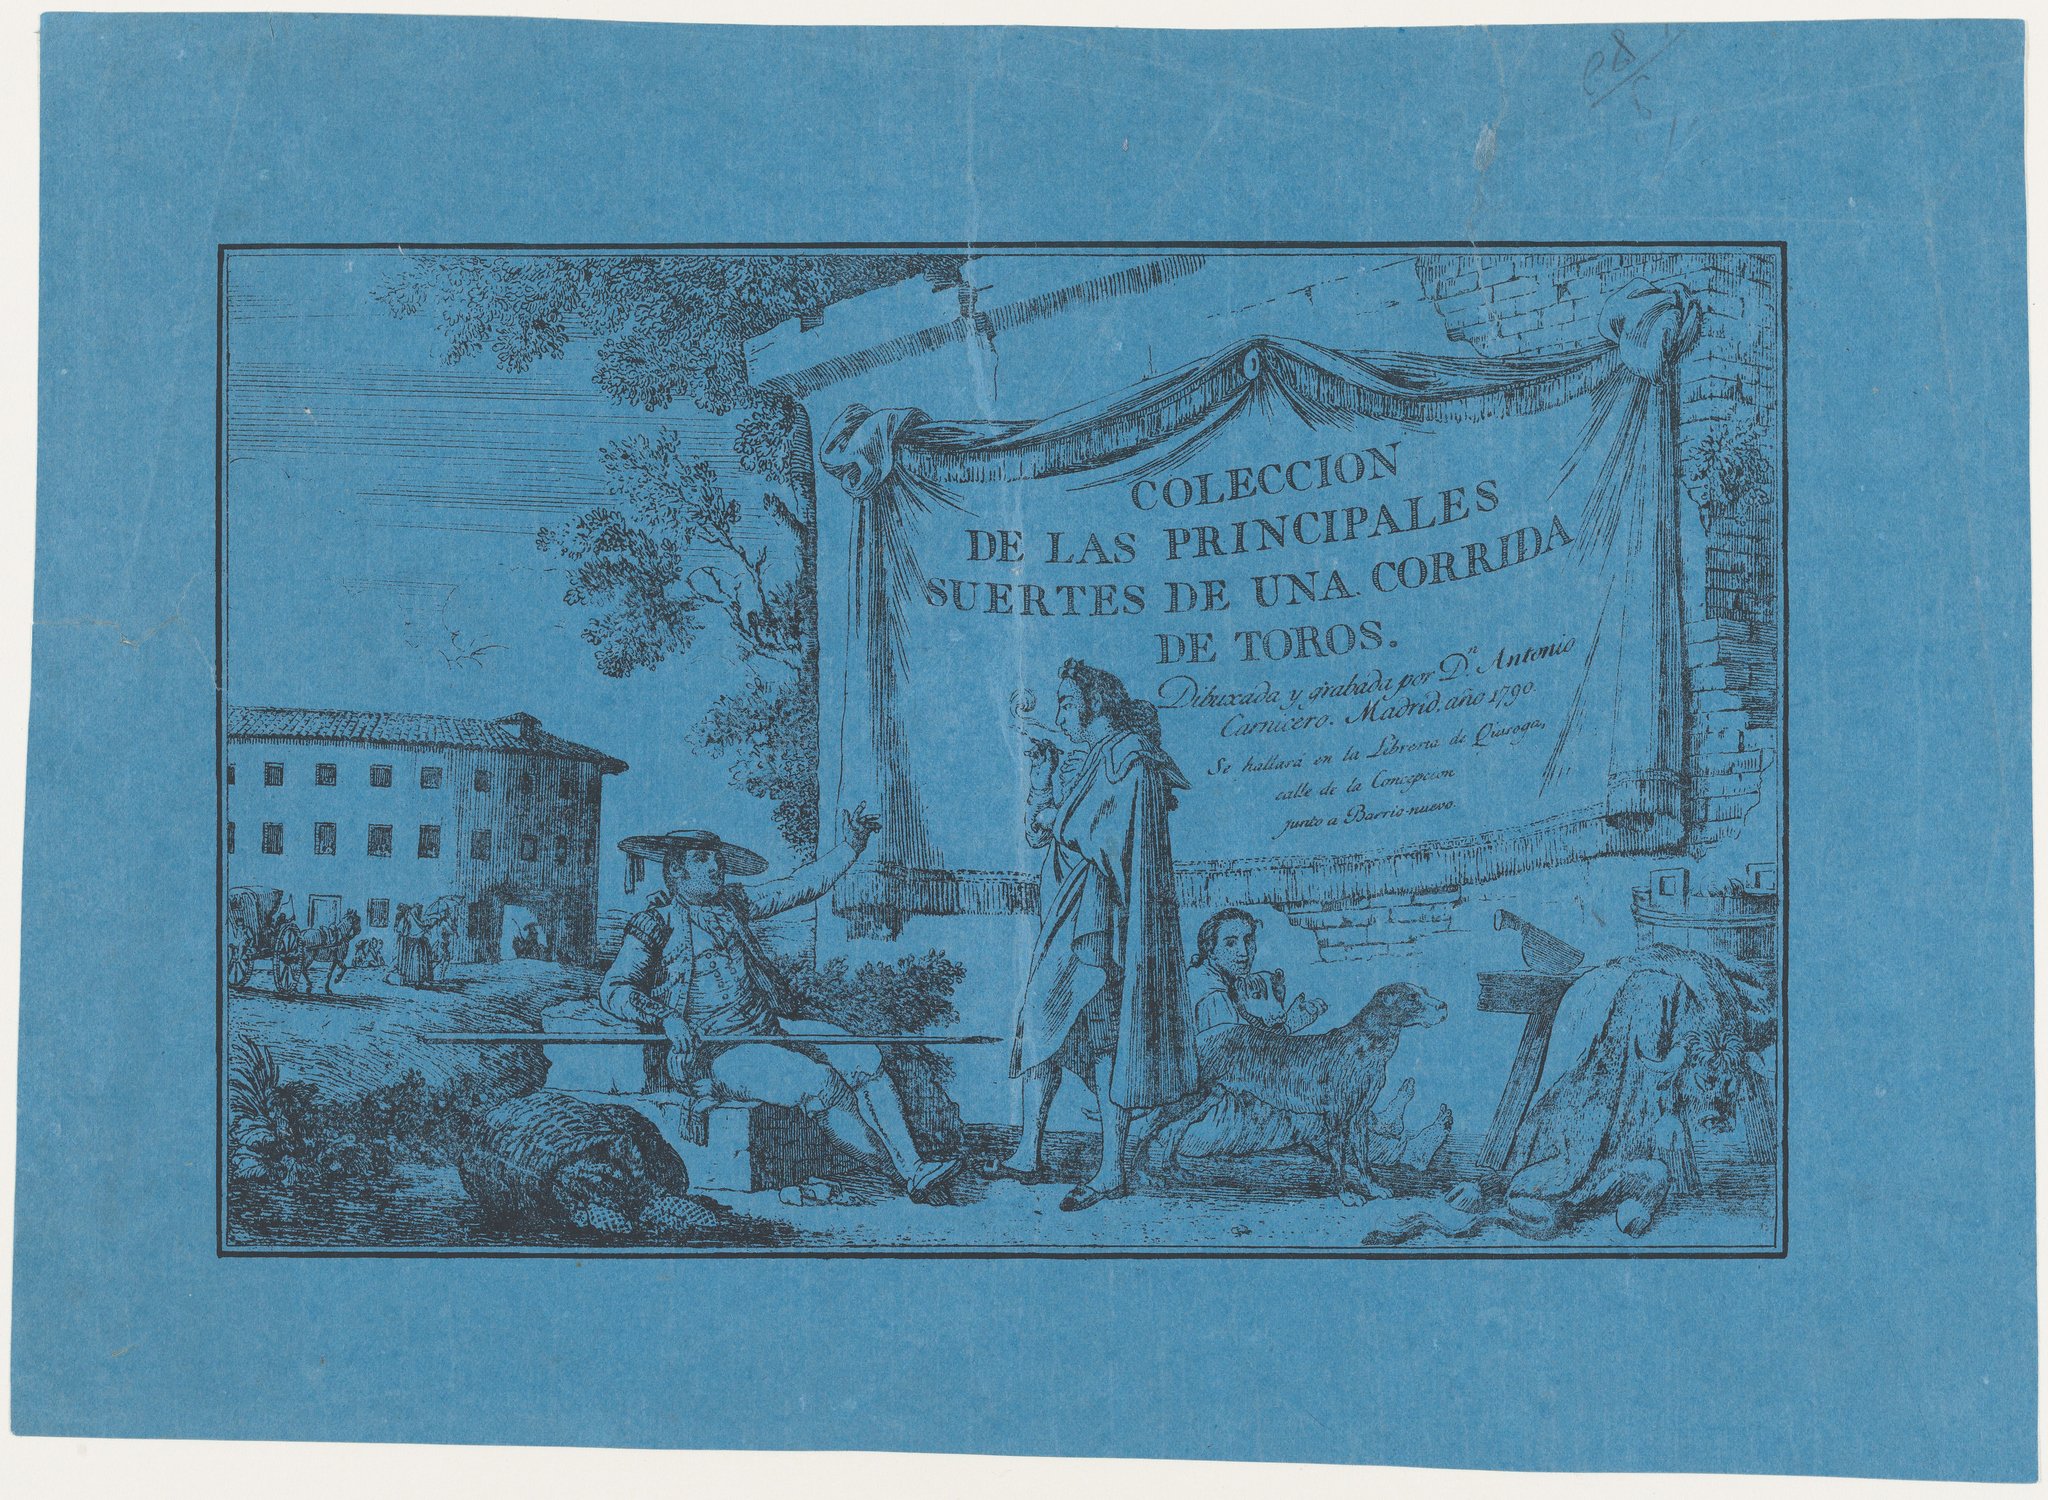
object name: print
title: Title page to the 'Colección de la principales suertes de una corrida de toros'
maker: antonio carnicero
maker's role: artist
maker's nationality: spanish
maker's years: 1748-1814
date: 1790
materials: paper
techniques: etching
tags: men,dogs